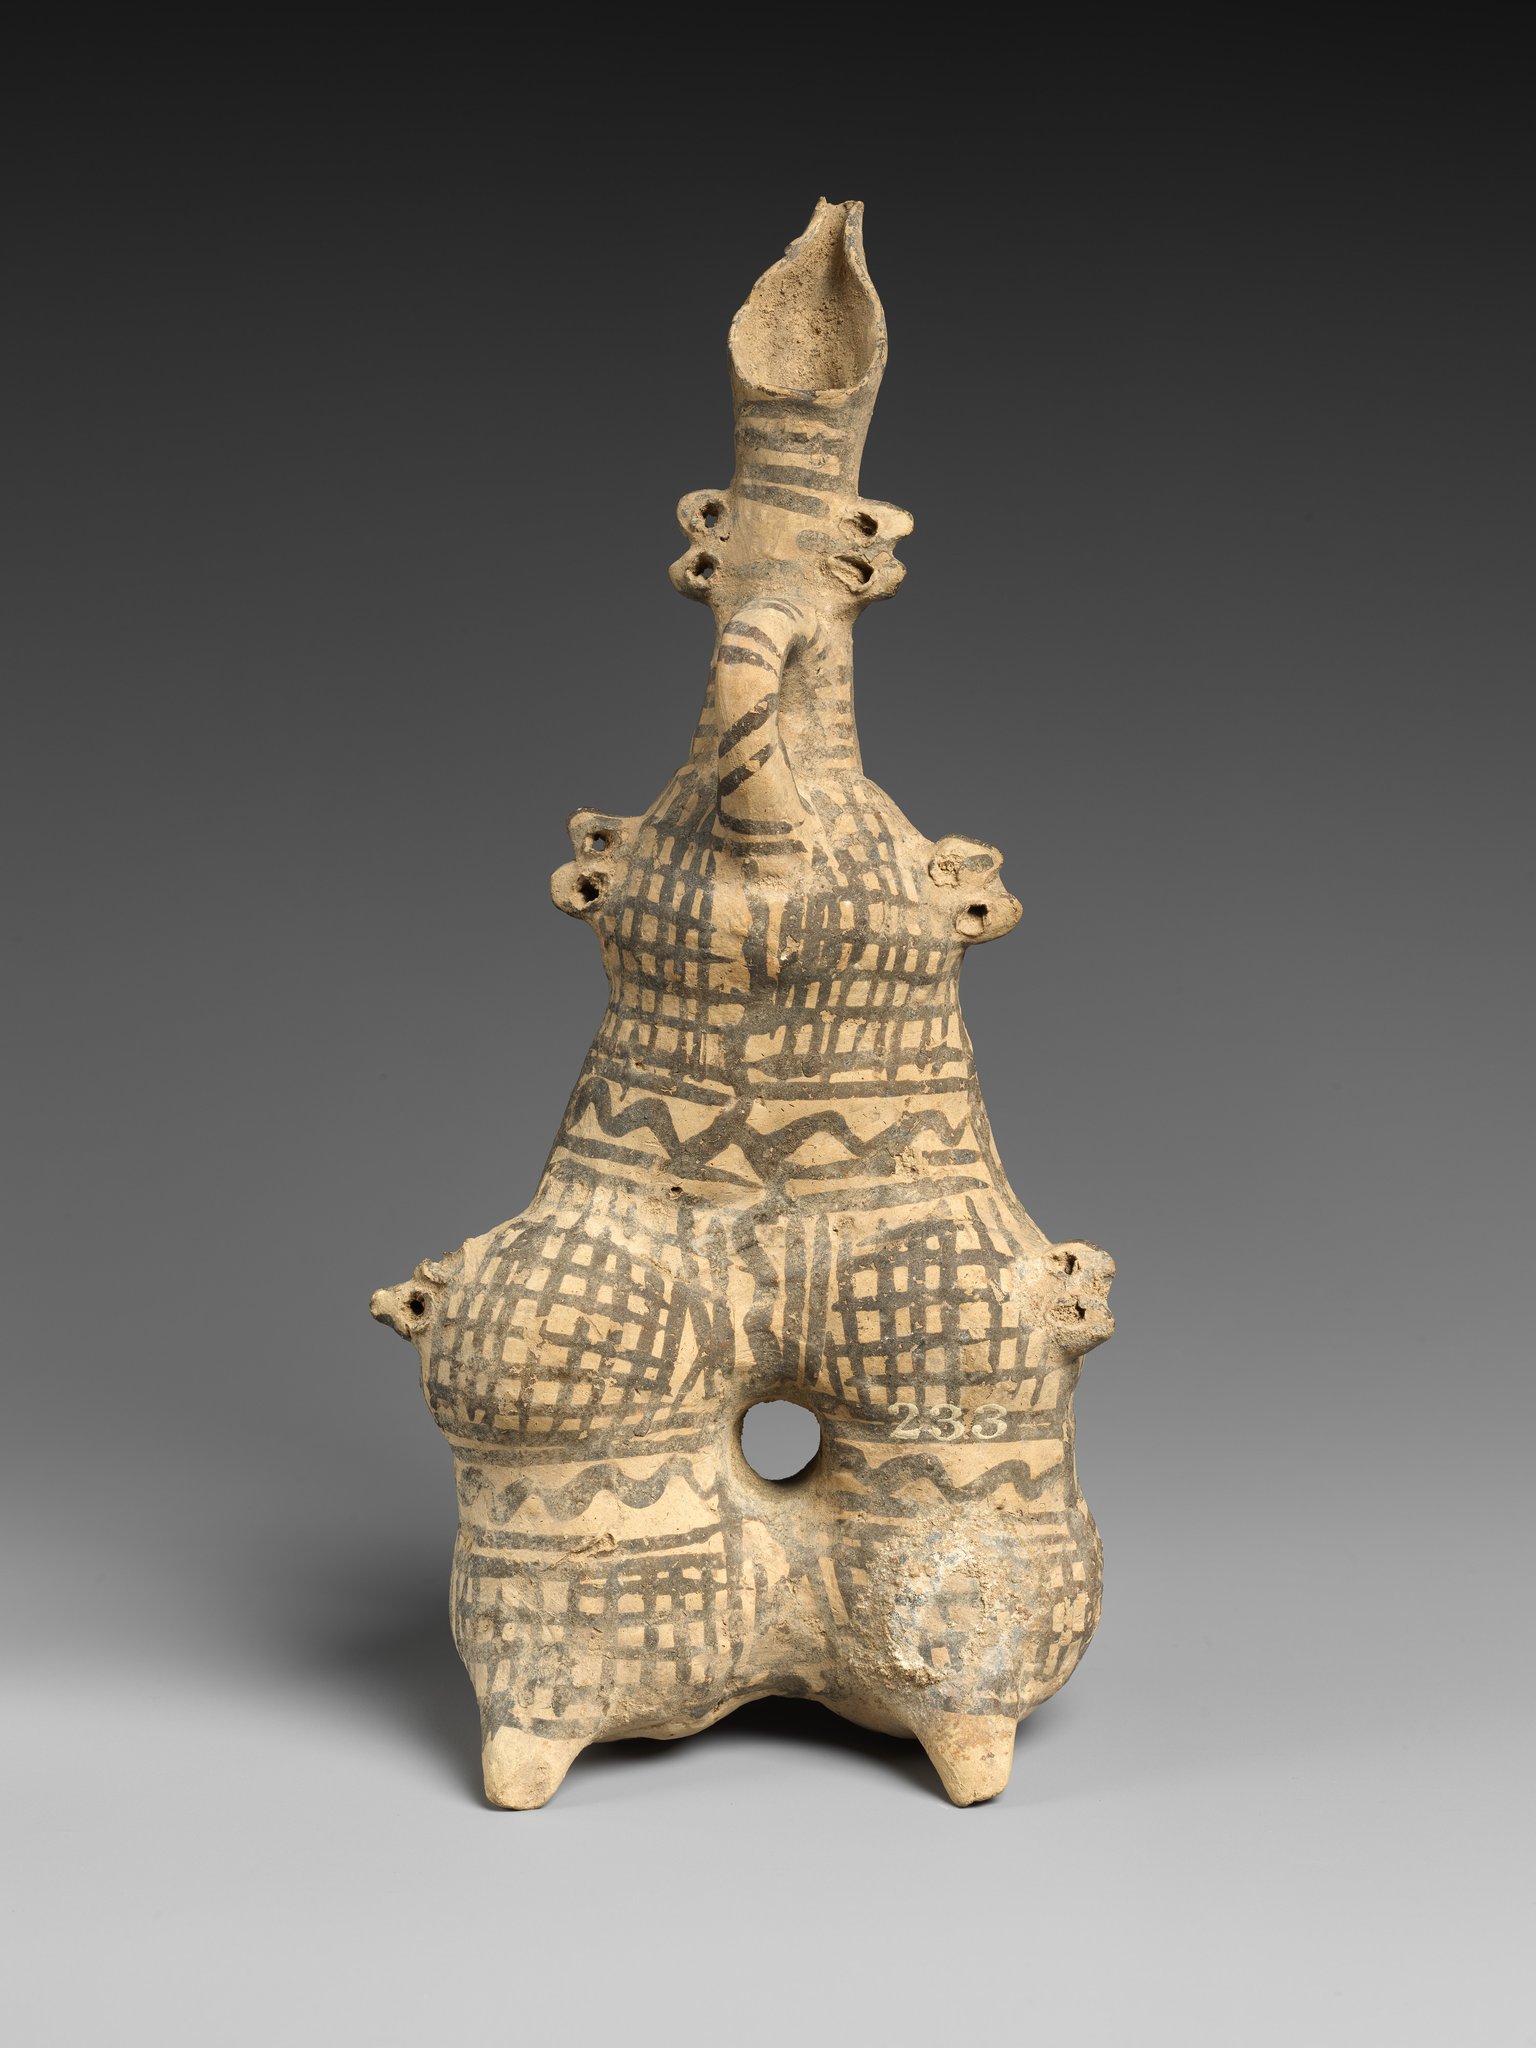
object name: composite jug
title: Terracotta composite jug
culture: cypriot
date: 1800-1725 BCE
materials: terracotta